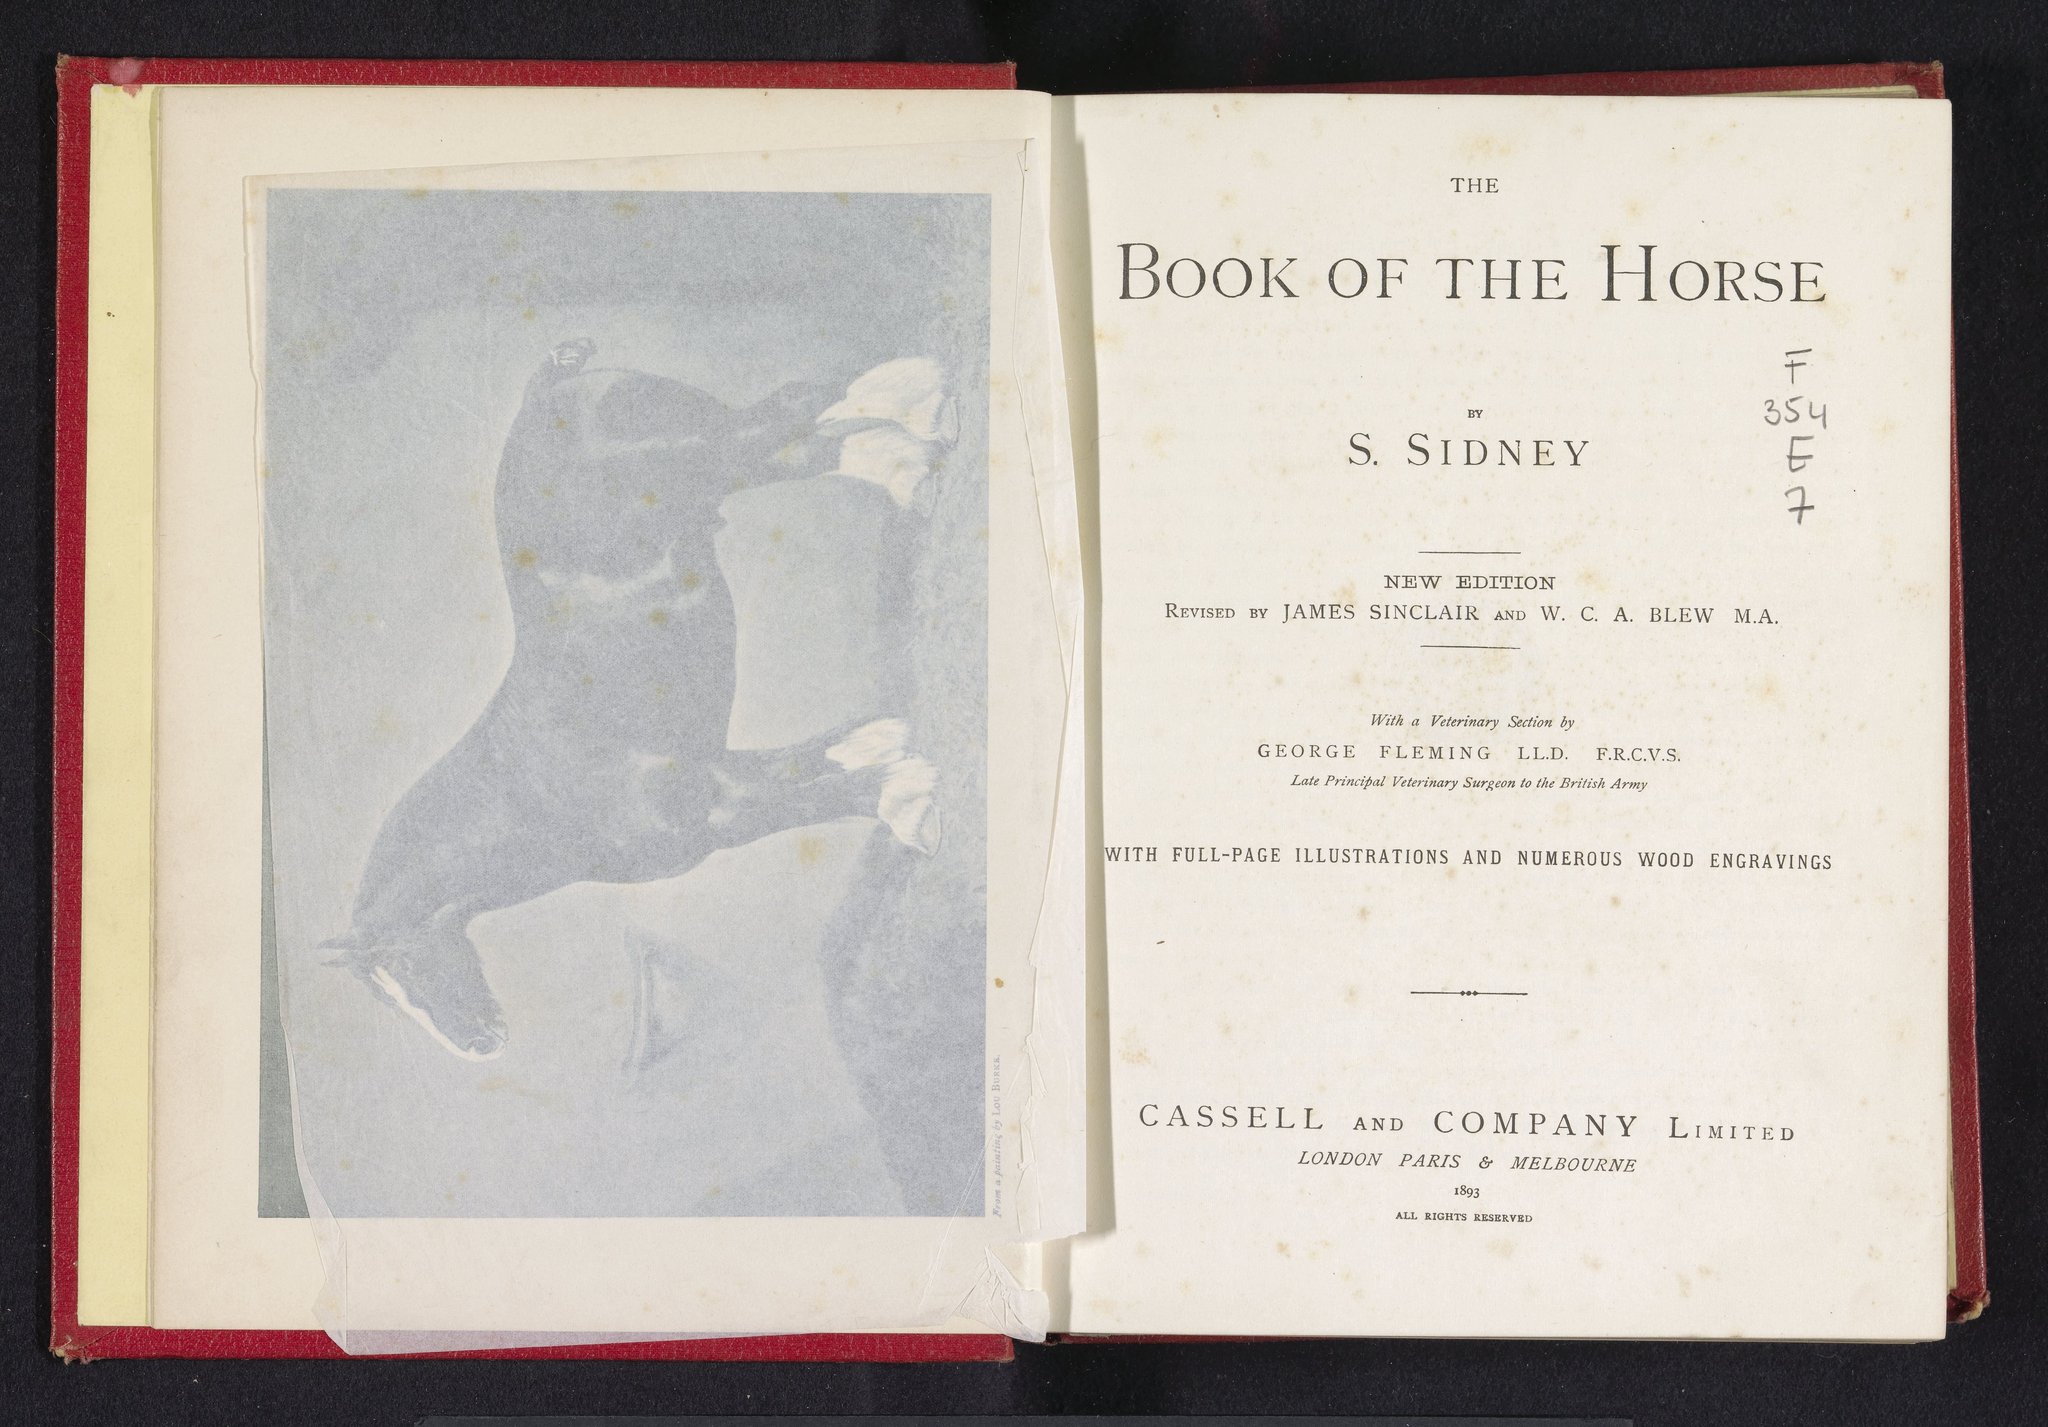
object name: book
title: The book of the horse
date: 1893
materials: linen, paper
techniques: photograph, printing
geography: london